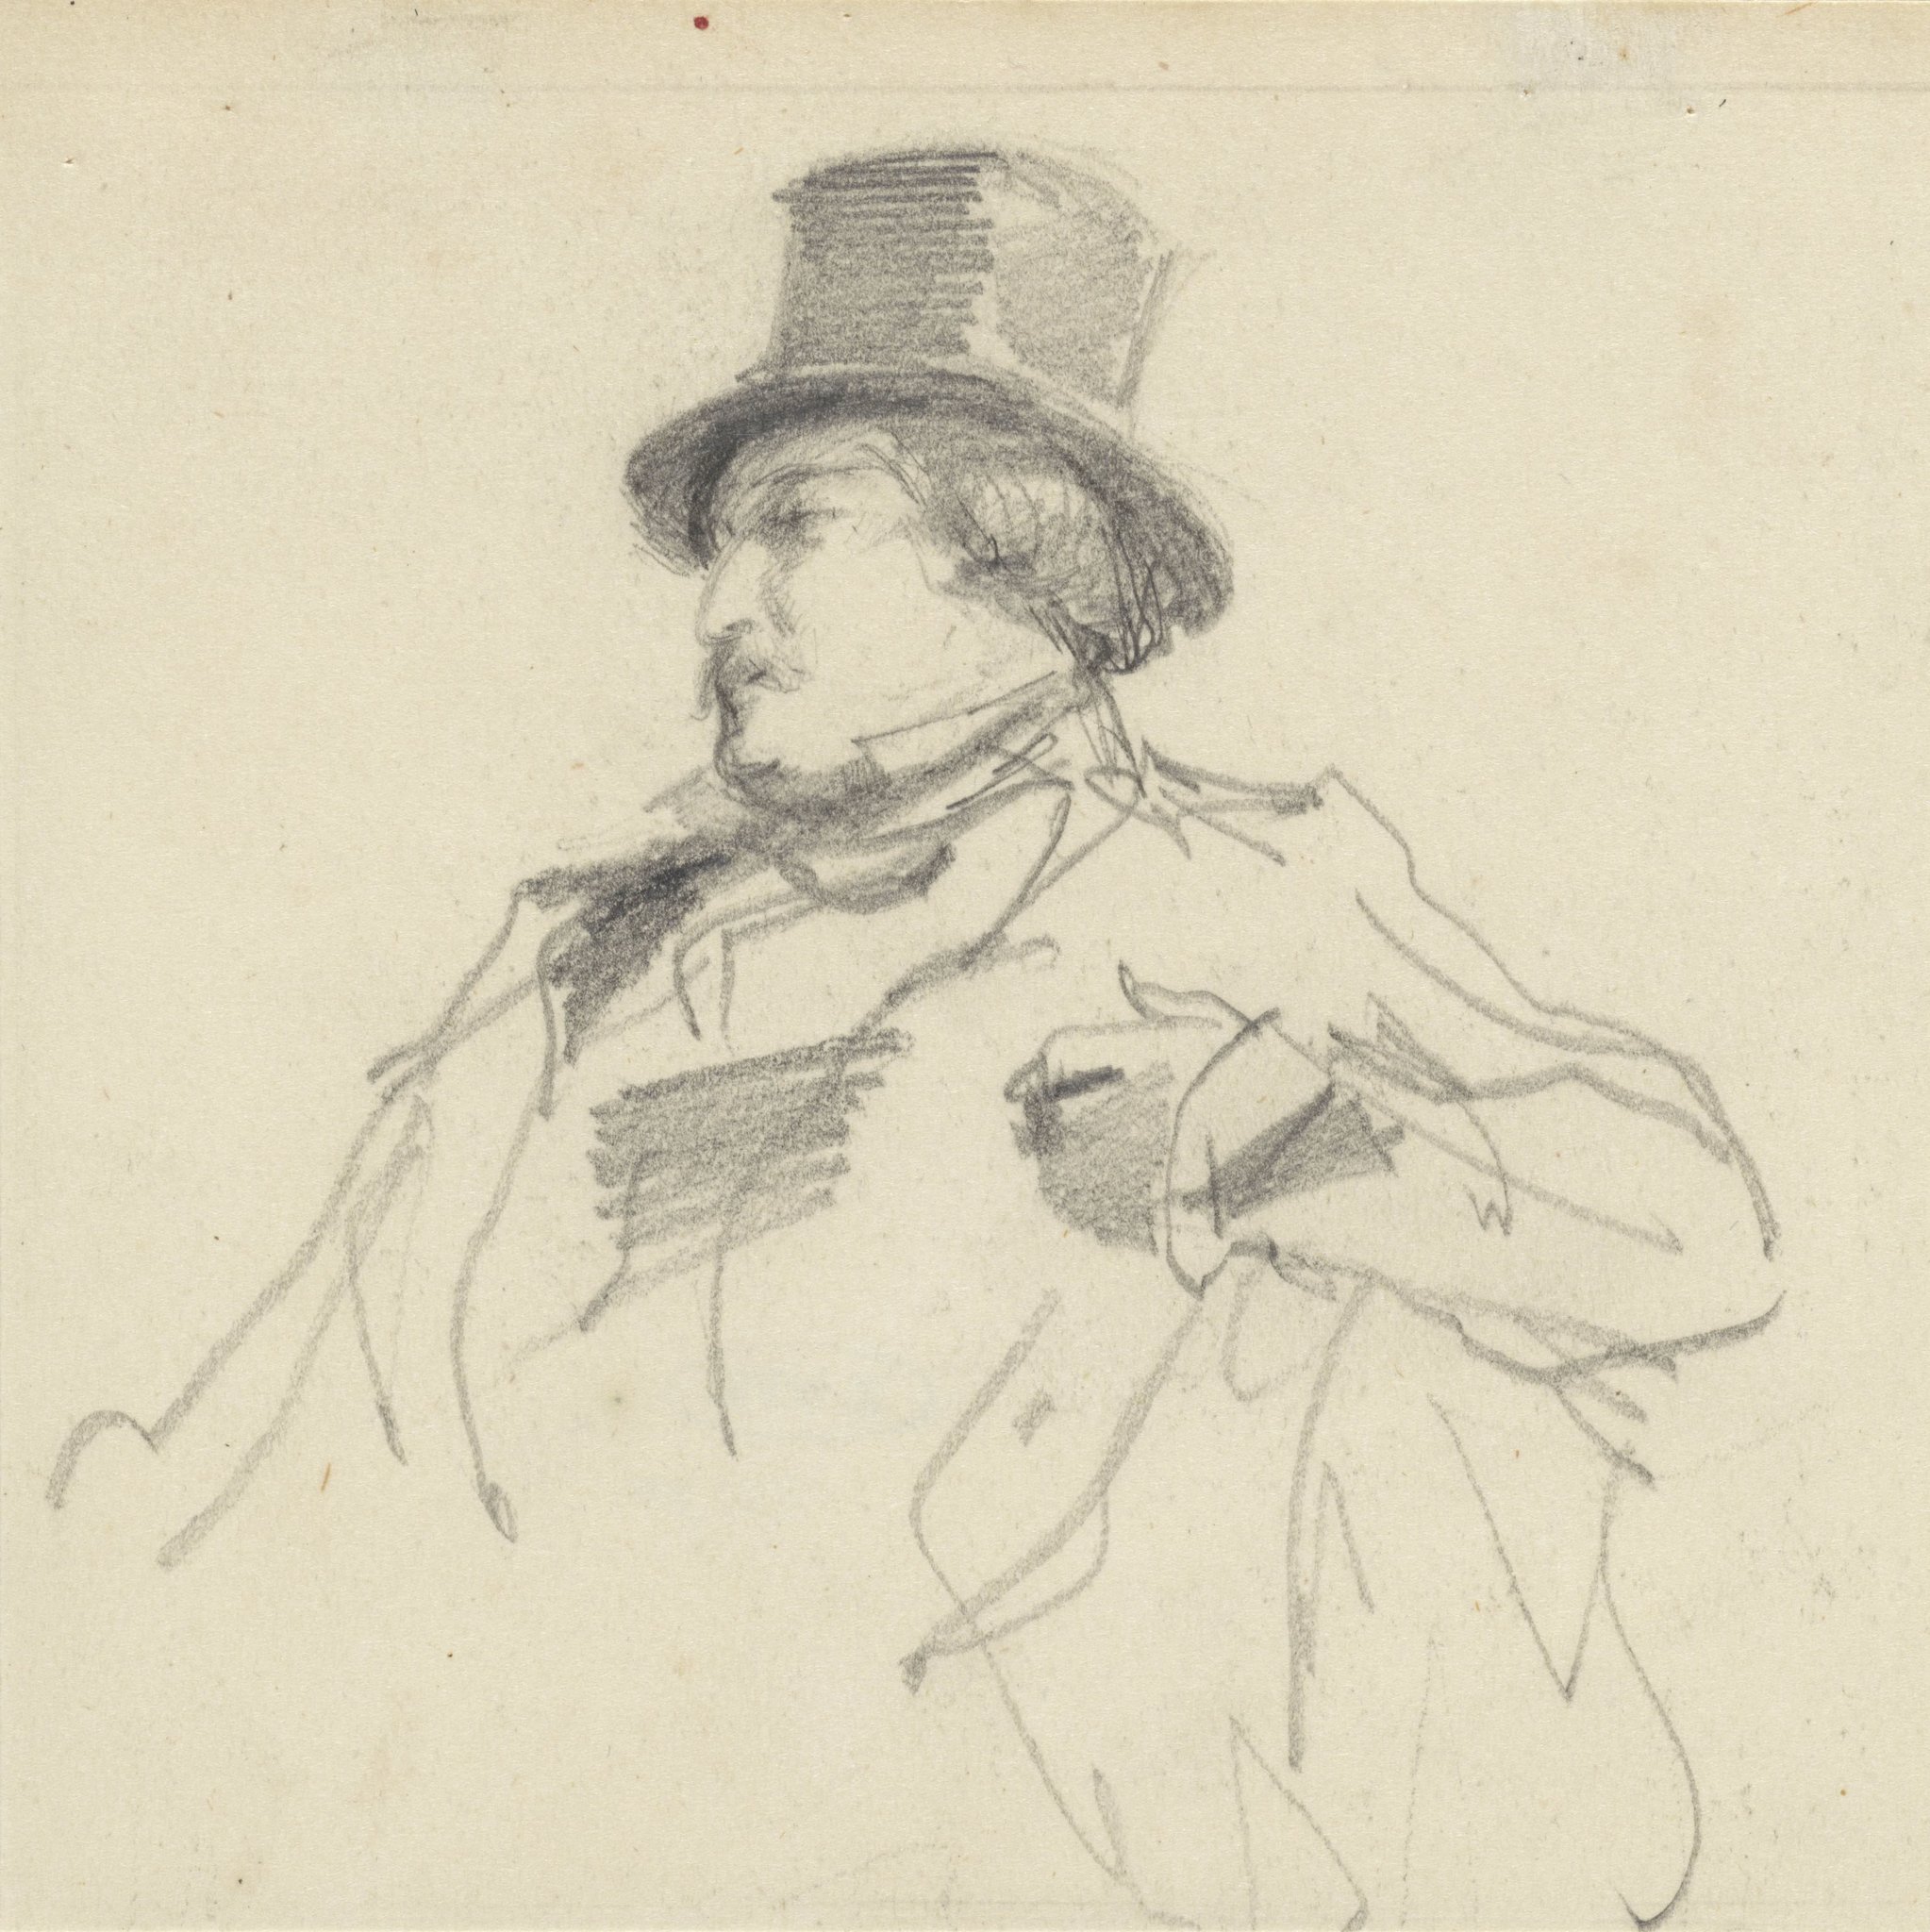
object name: drawing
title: Schets van een man met een hoge hoed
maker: charles rochussen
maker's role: draughtsman, painter, print maker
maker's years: 1814-1894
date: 1824-1894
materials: paper, pencil